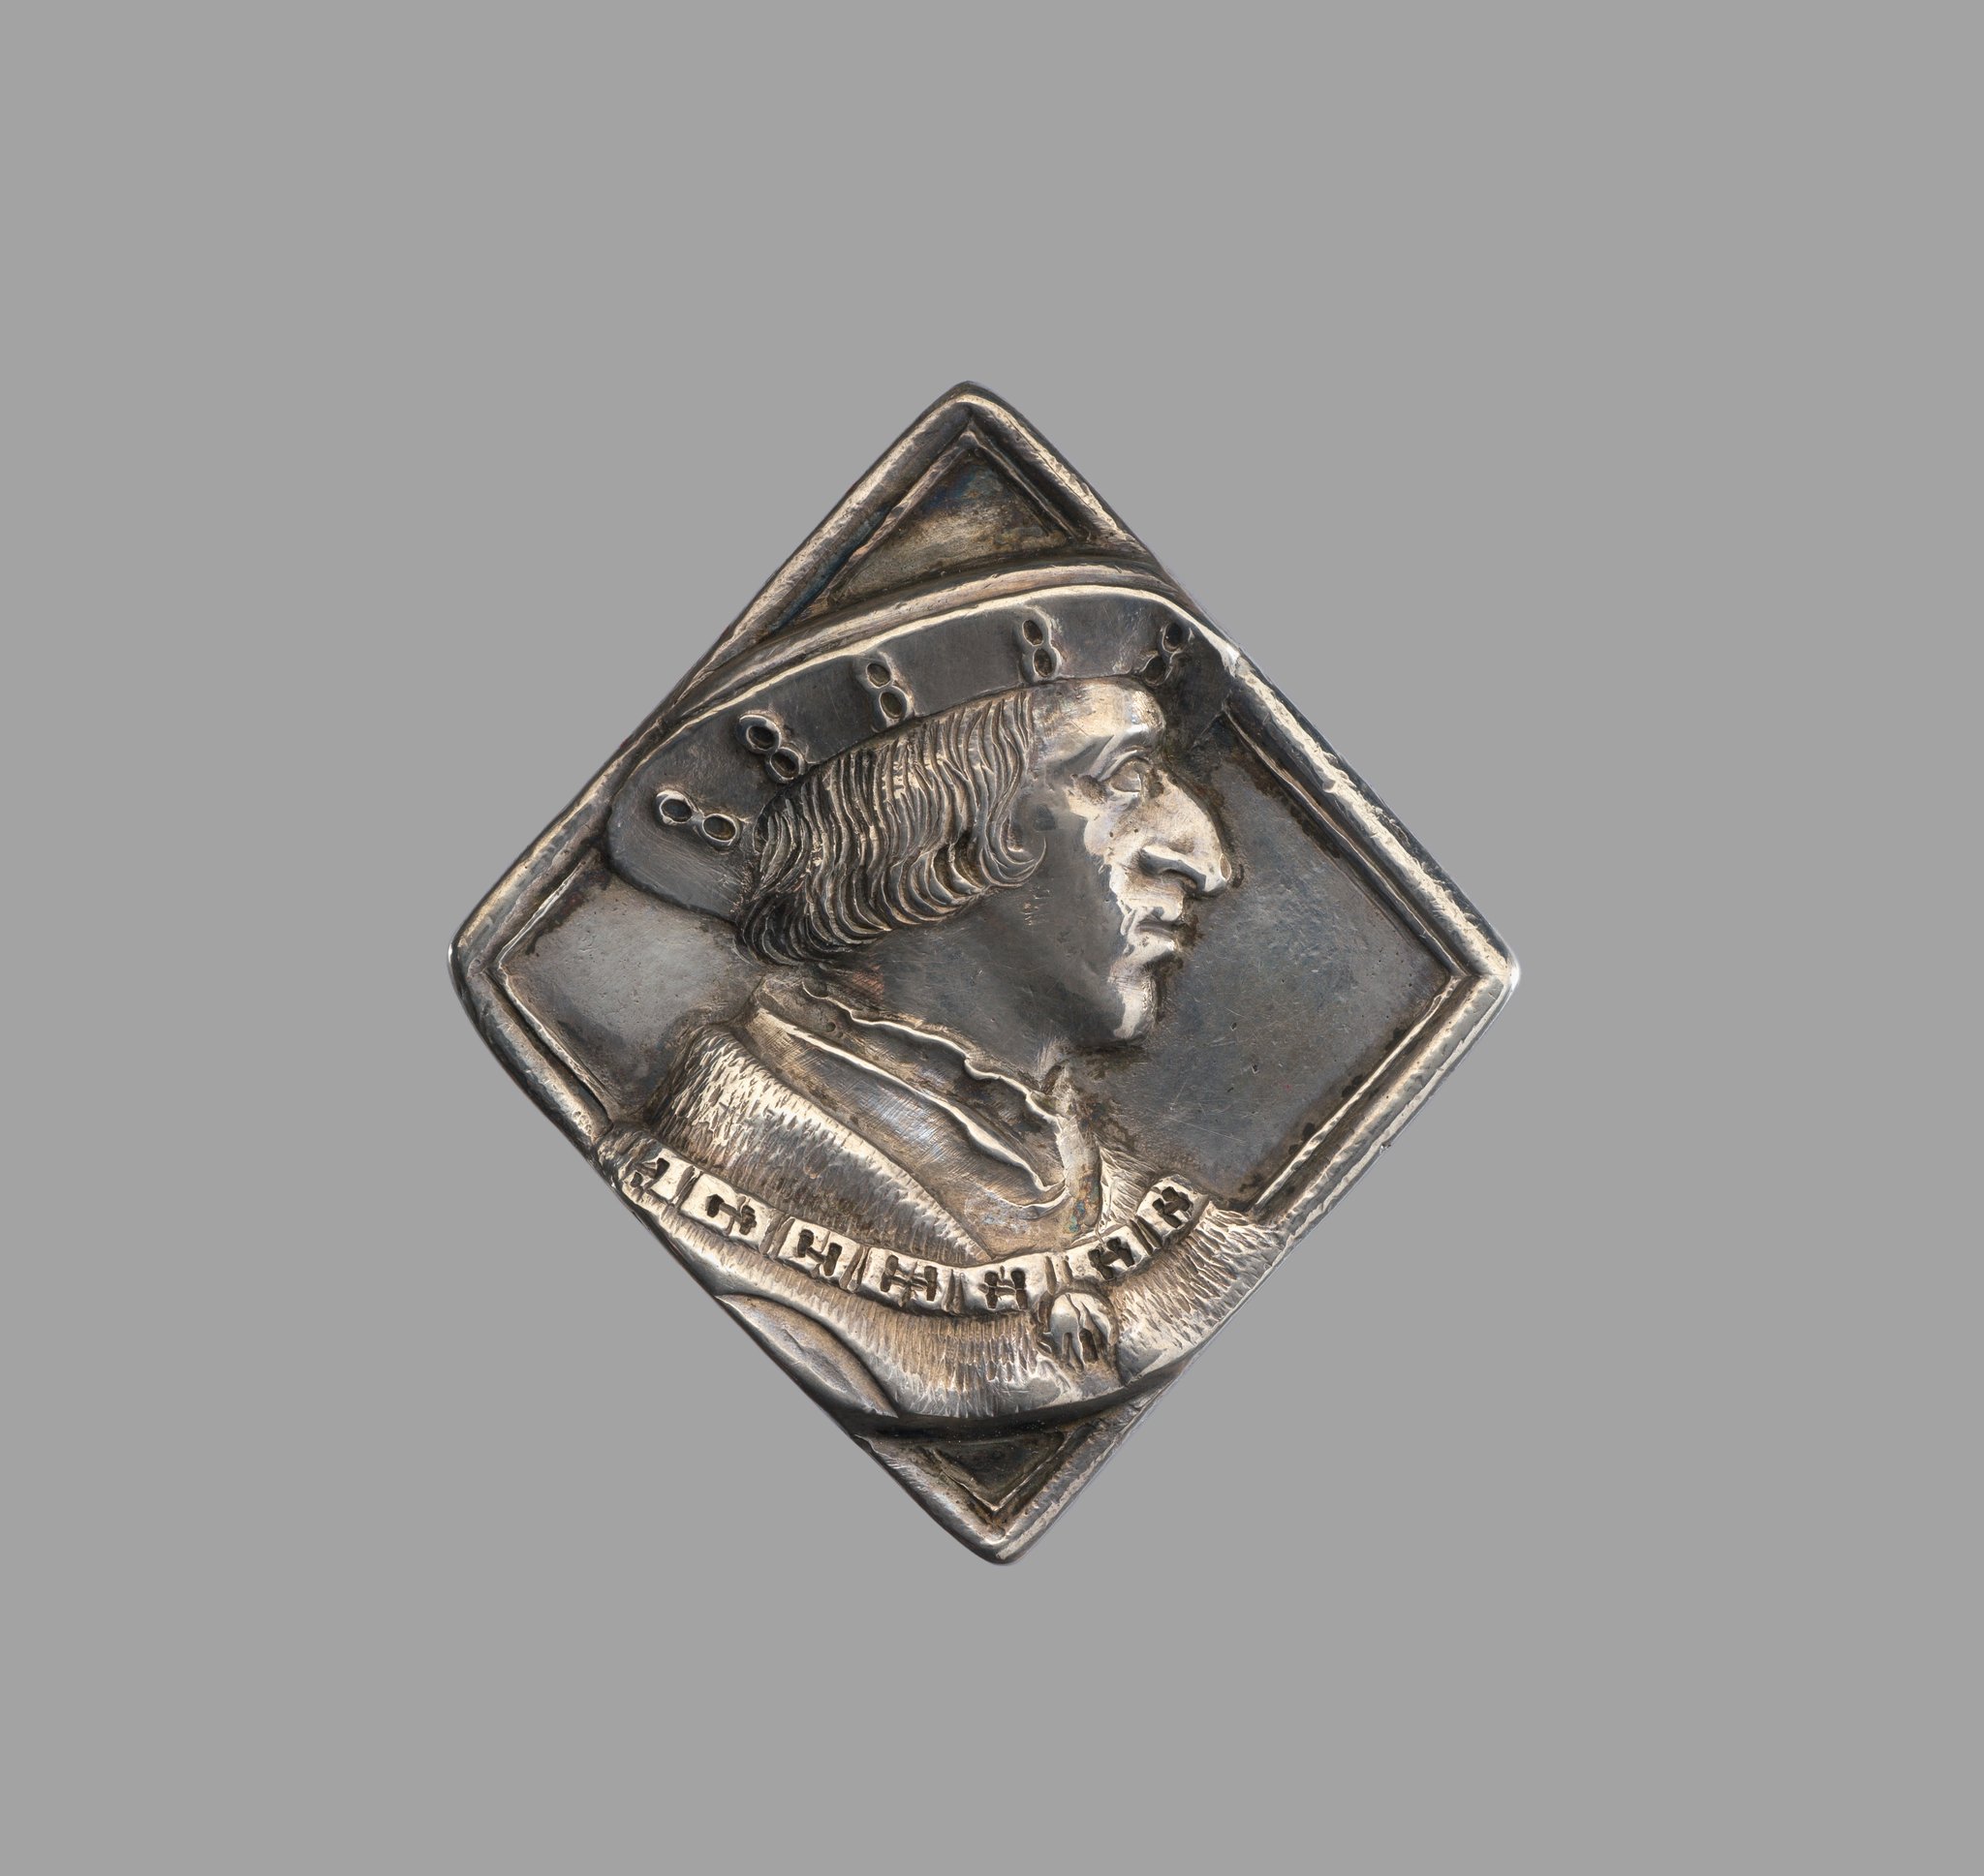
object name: medal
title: Maximilian I, Holy Roman Emperor (1493–1519)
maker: hans reinhart the elder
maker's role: artist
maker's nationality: german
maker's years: 1500-1581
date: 1540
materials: silver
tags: emperors,men